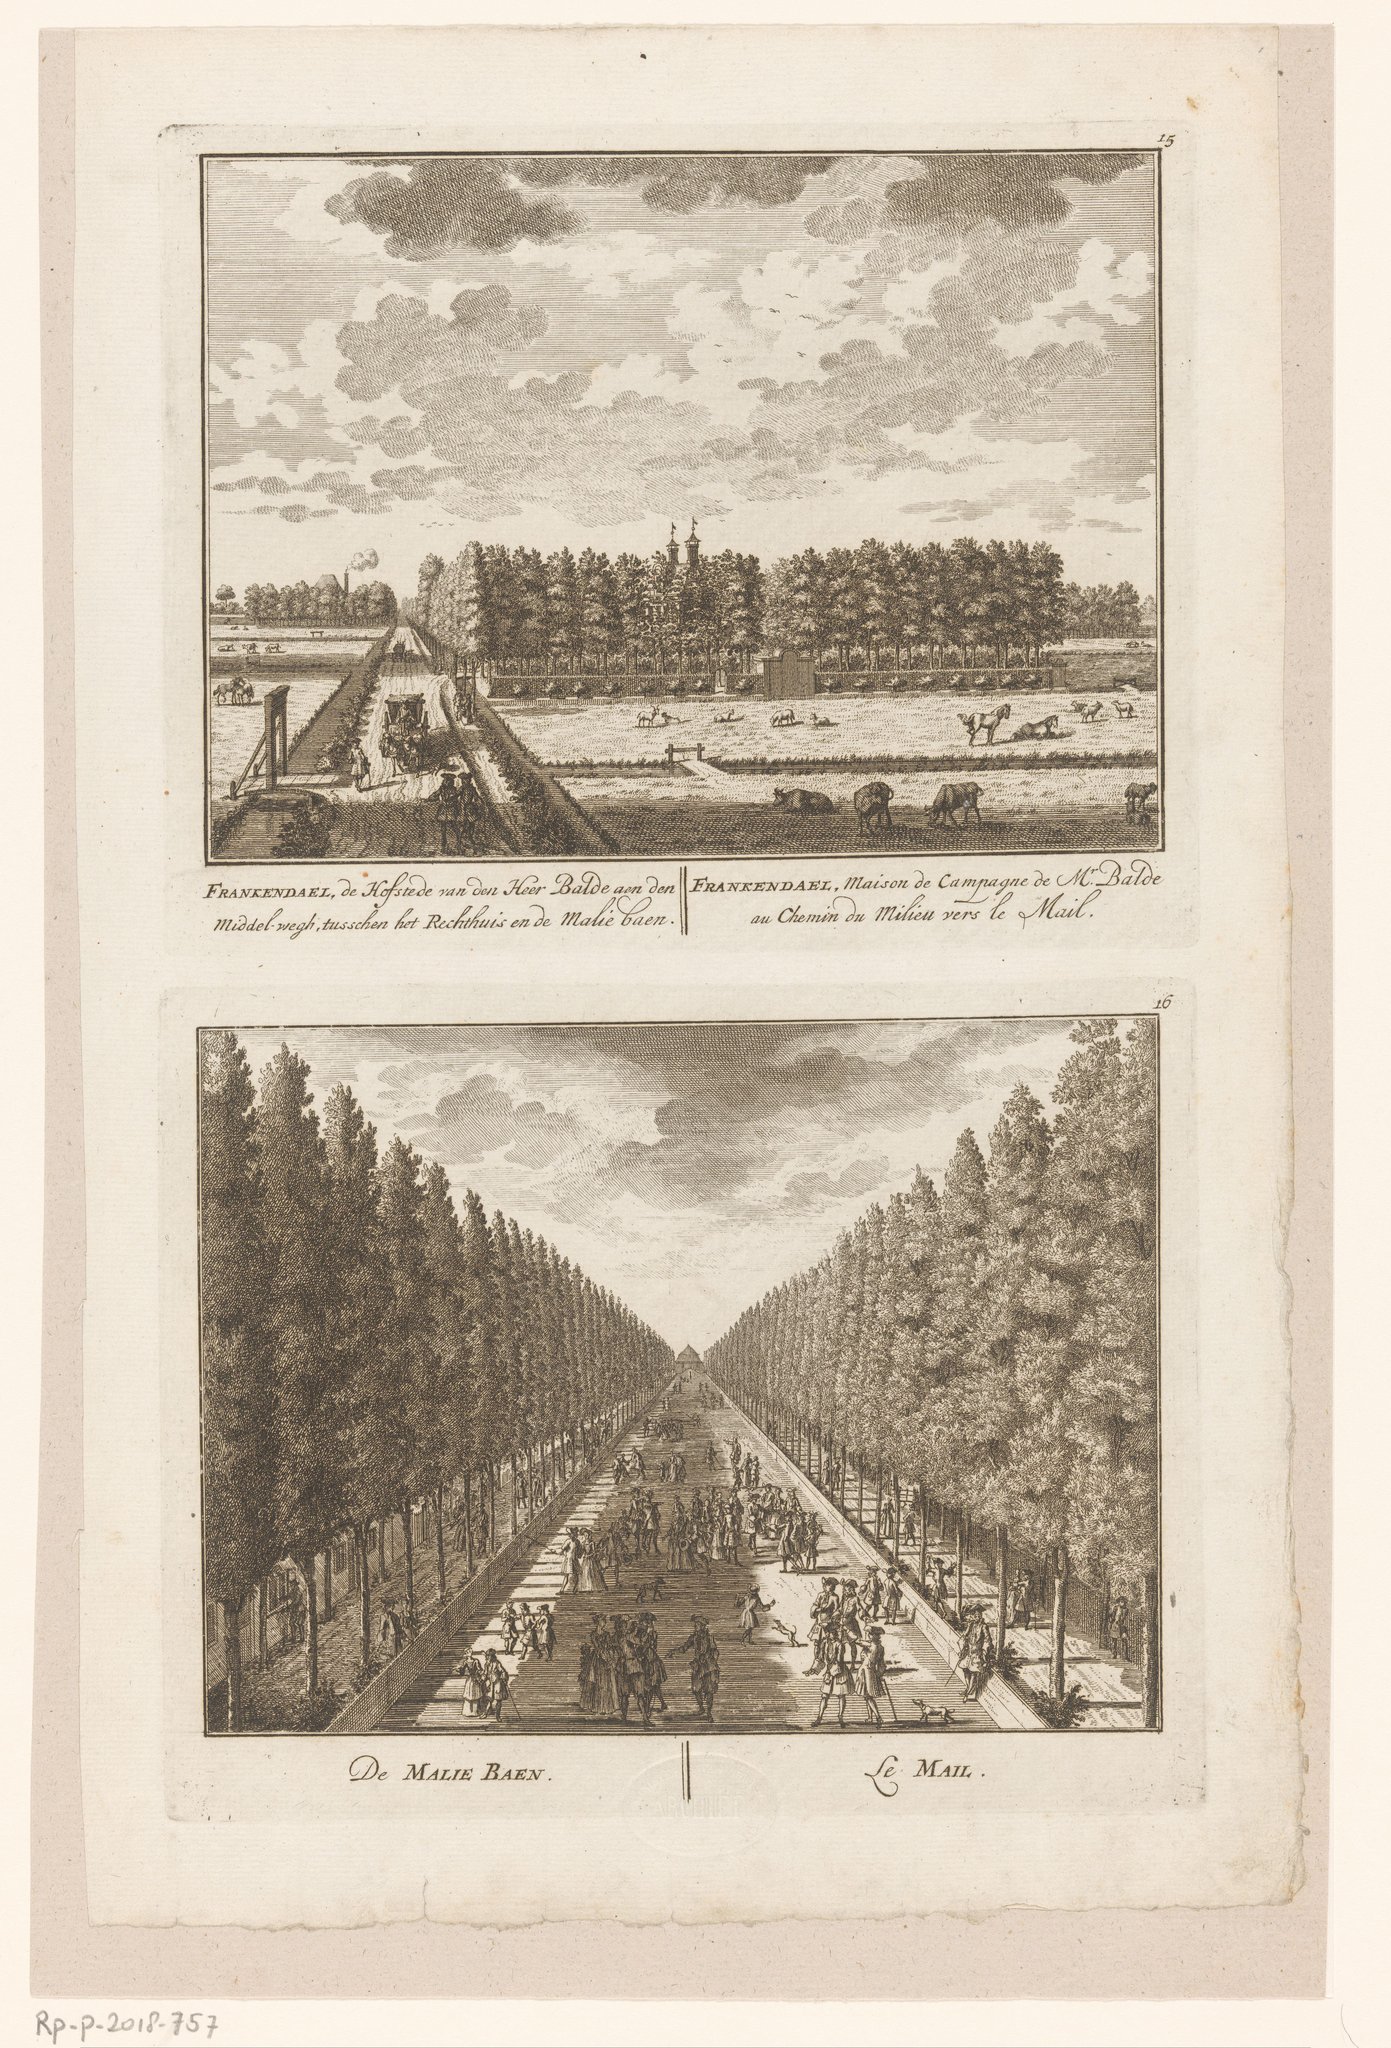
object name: book illustration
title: Gezicht op buitenplaats Frankendael en een gezicht op de Maliebaan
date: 1725-1768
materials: paper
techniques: engraving, etching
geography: amsterdam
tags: 'maille' (ball game), public road, country-house, amsterdam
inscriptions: check stamp: ‘Archief Ministerie van Oorlog Afdeeling Genie’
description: Prent gebruikt in: Niedek, Mattaeus Brouërius. Het verheerlykt Watergraafs- of Diemermeer by de stadt Amsterdam (...). Amsterdam: Andries en Hendrik de Leth, 1725. Of in: Niedek, Mattaeus Brouërius. Het verheerlykt Watergraafs- of Diemermeer by de stadt Amsterdam (...). Amsterdam: Pieter Jan Entrop, 1768.